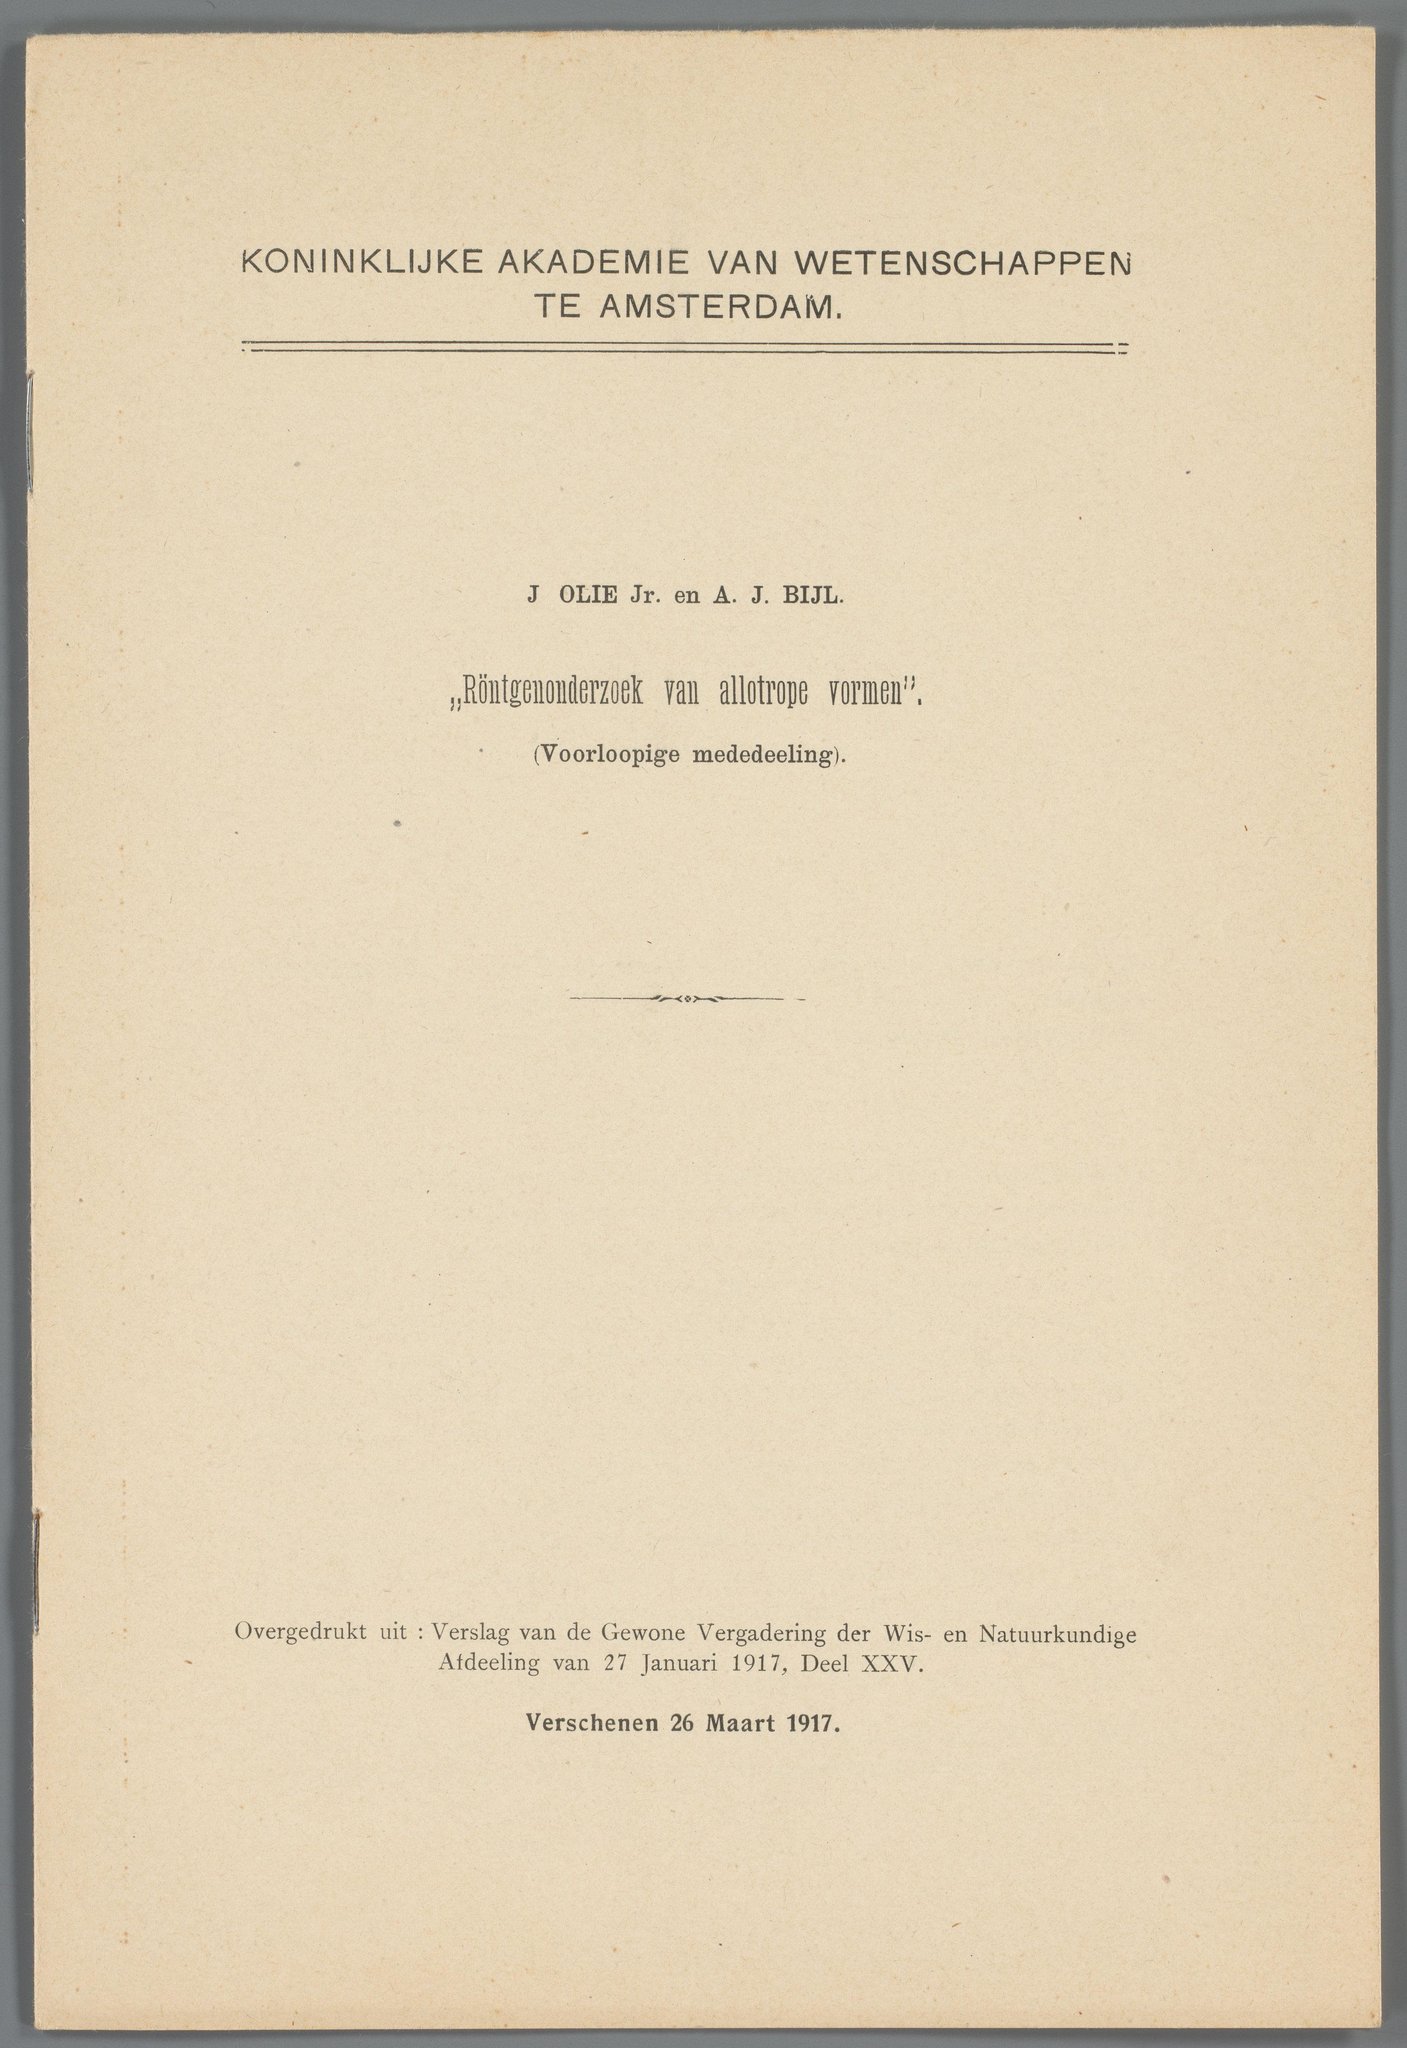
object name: offprint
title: Verslag van röntgenonderzoek van allotrope vormen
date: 1917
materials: paper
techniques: letterpress printing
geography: utrecht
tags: printed matter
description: Overdruk uit het verslag van de 'Gewone Vergadering der Wis- en Natuurkundige Afdeeling' op 27 januari 1917.